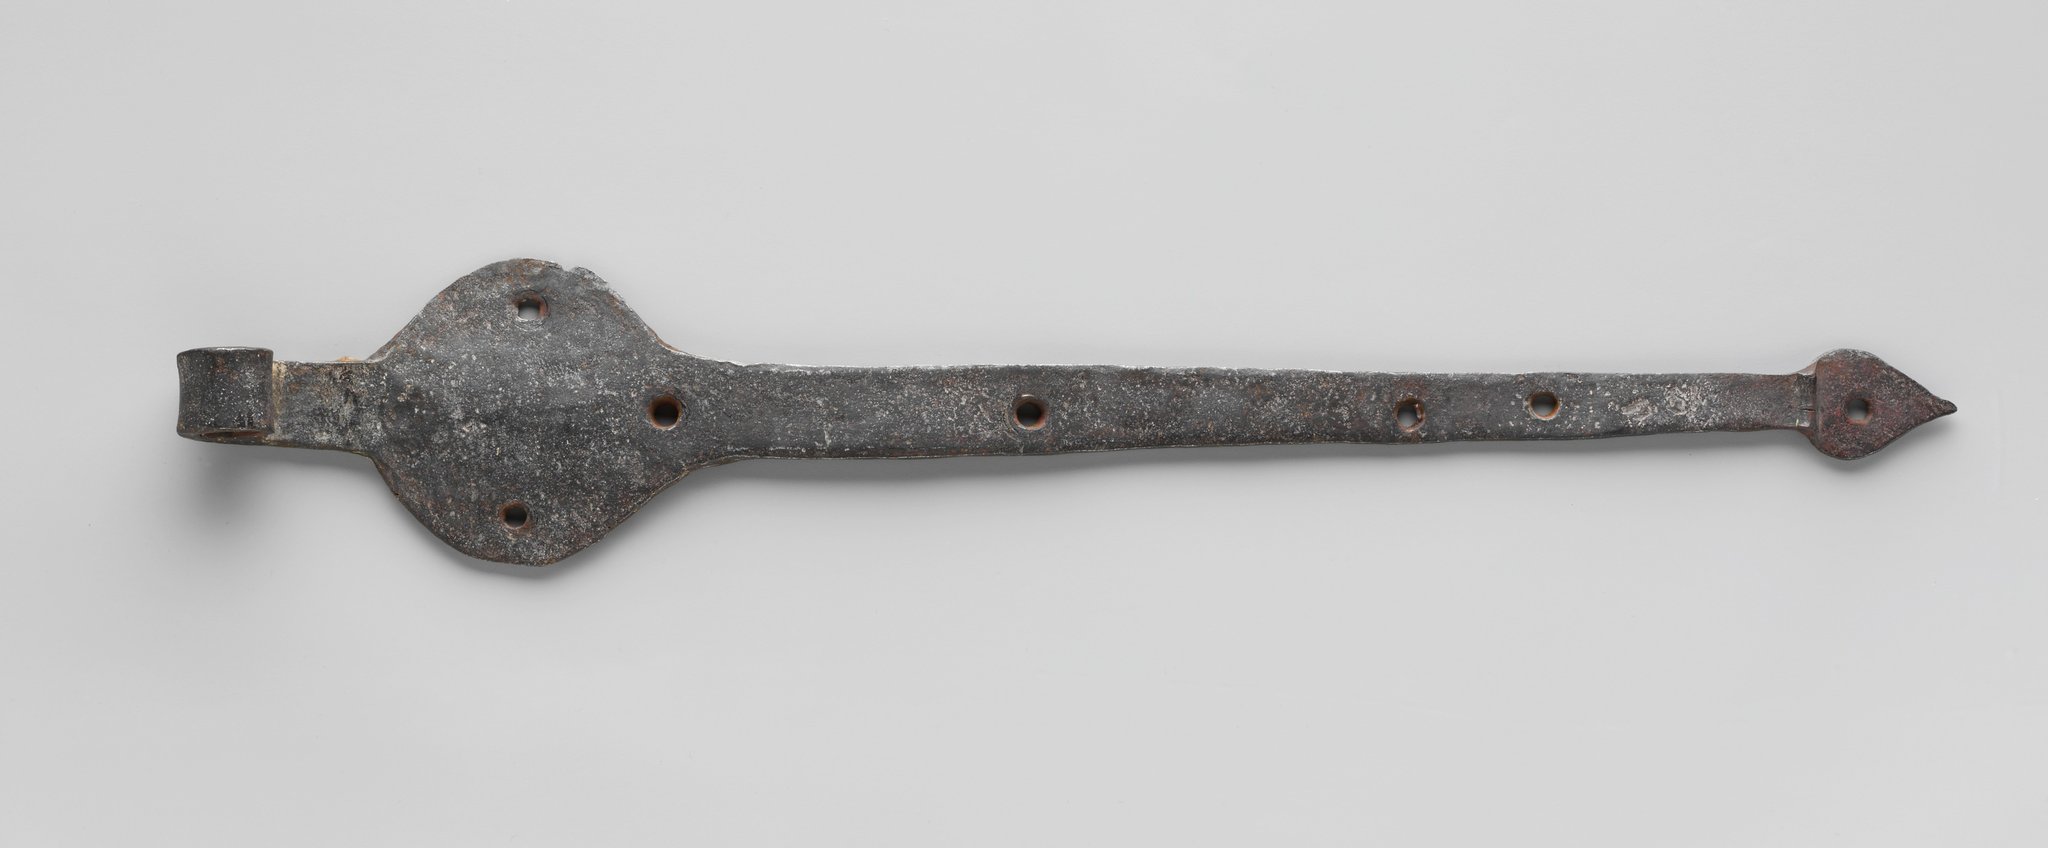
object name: hinge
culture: american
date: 1700-1800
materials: iron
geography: united states